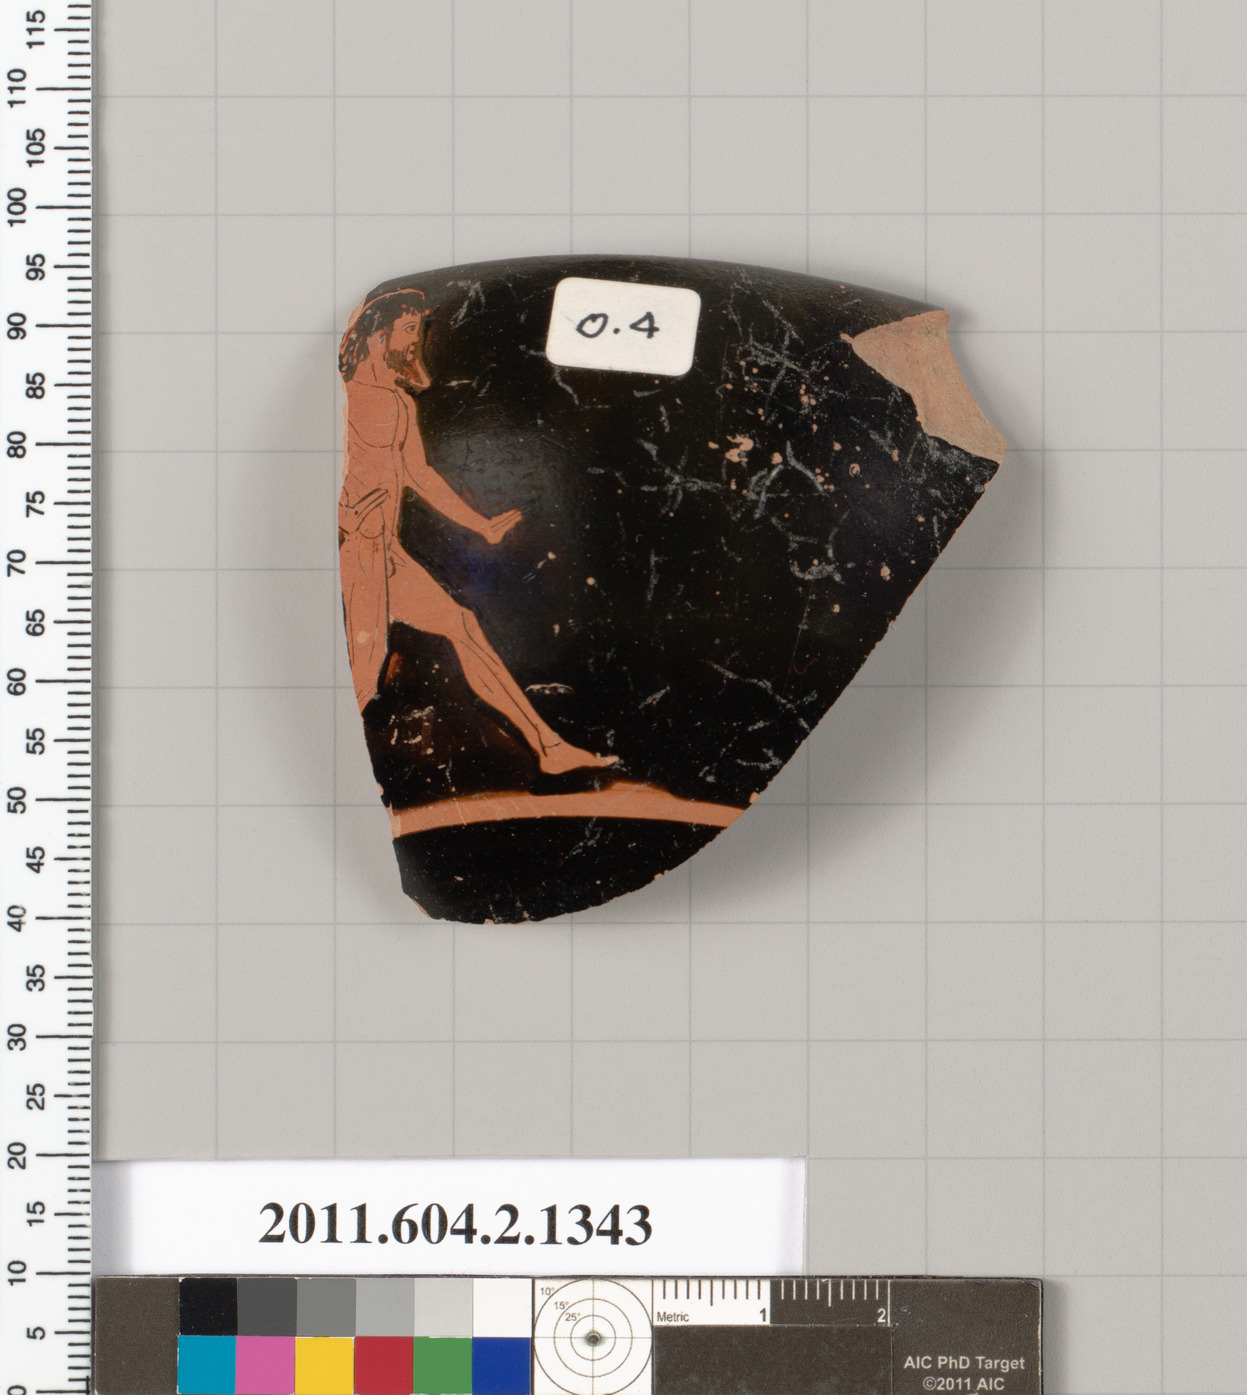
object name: skyphos fragment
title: Terracotta fragment of a skyphos (deep drinking cup)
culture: greek, attic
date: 450-426 BCE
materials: terracotta